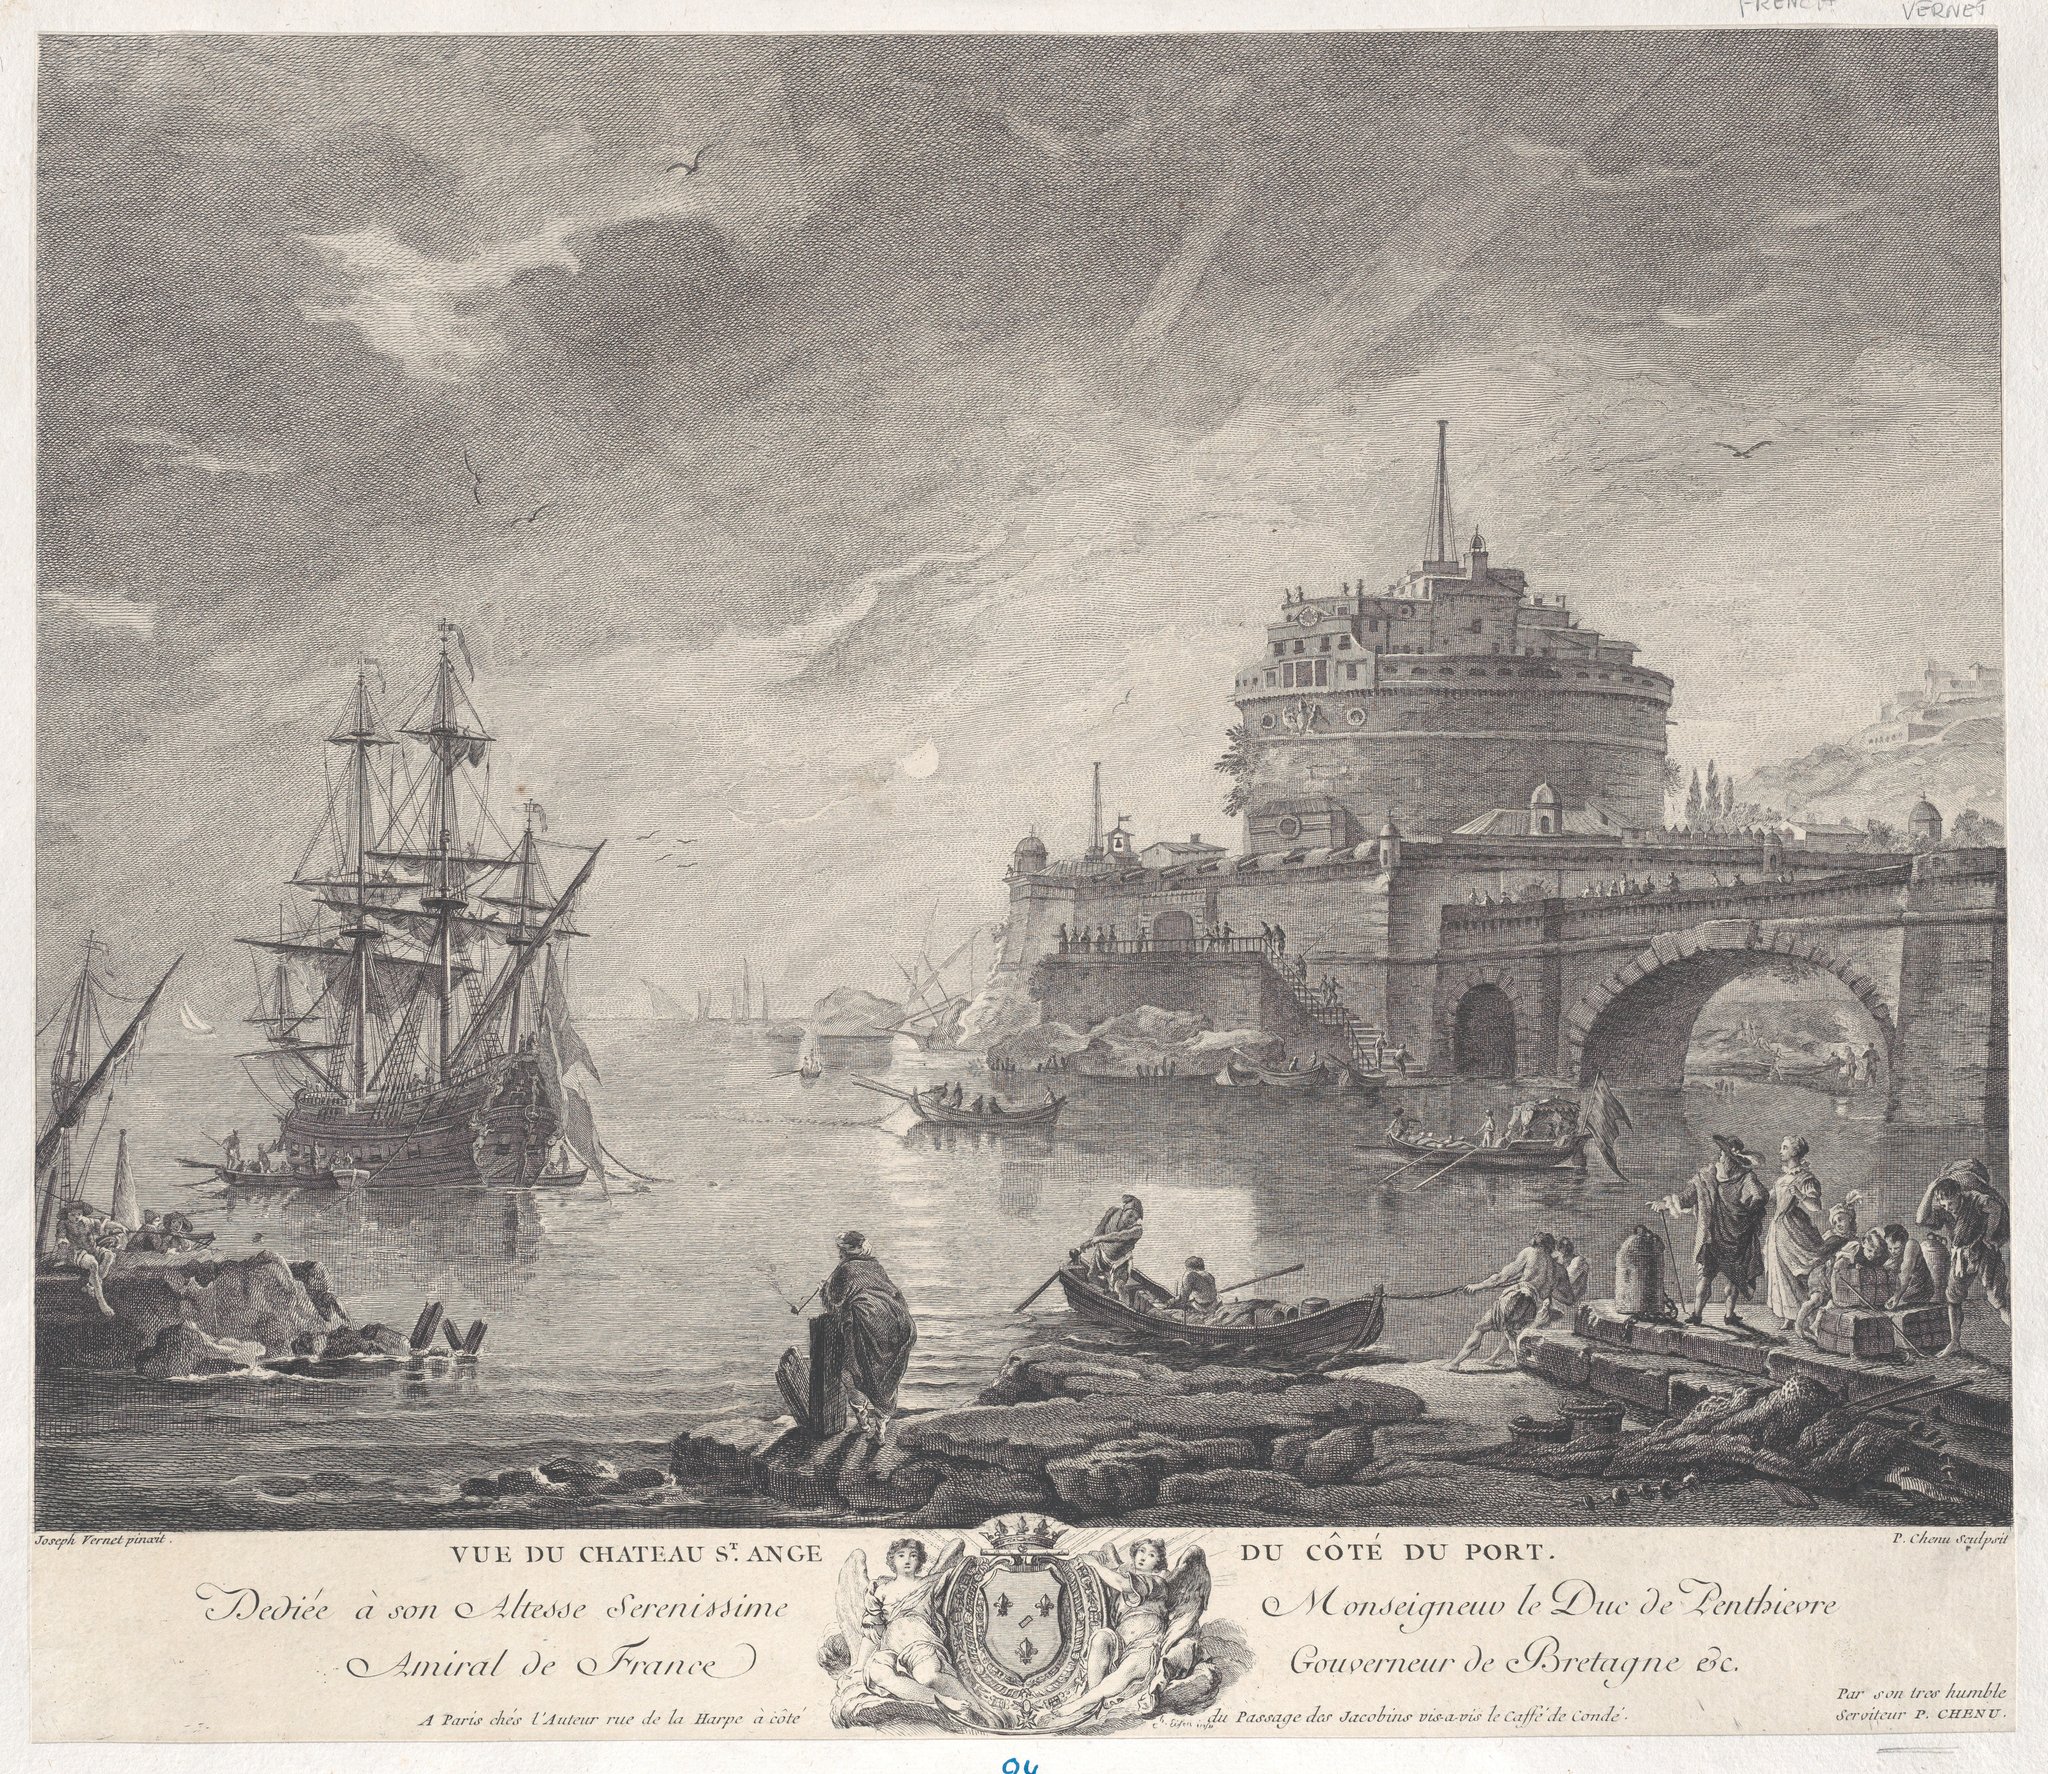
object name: print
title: View of Saint Angel's Castle from Port Side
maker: joseph vernet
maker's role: artist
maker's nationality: french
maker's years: 1714-1789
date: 1760-1800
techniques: engraving